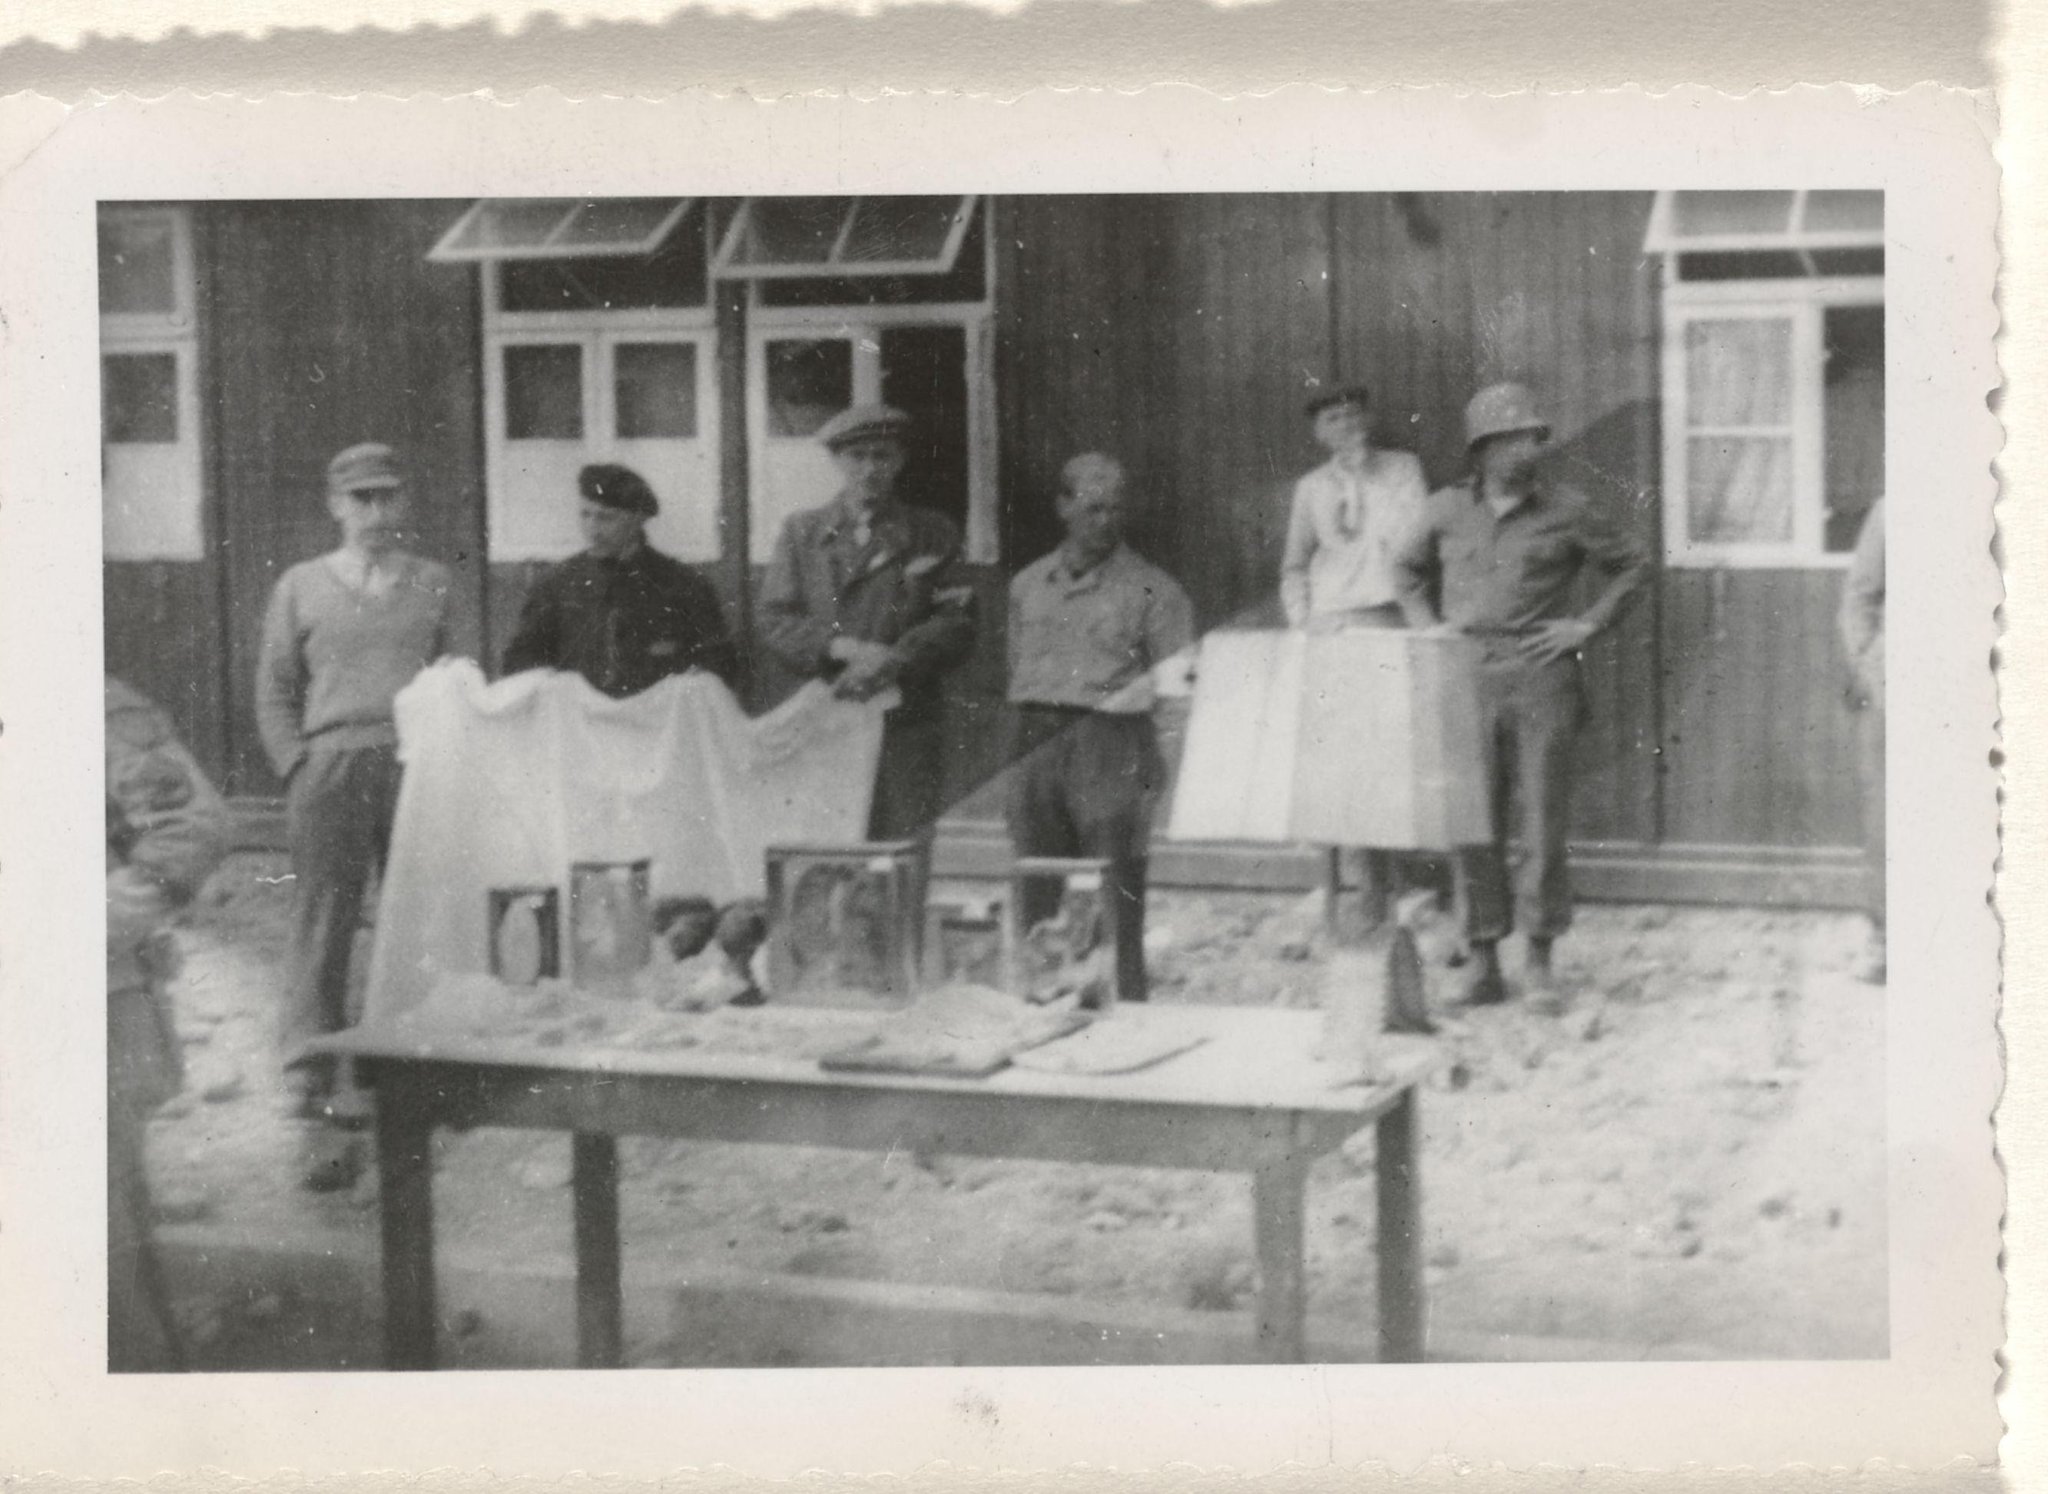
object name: photograph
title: Voormalige kampgevangenen en Amerikaanse soldaten, april 1945?, concentratiekamp Buchenwald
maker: Anonymous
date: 1904-1945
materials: photographic support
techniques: gelatin silver print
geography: buchenwald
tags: buchenwald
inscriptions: inscription: ‘K.Z. Buchenwald’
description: Voormalige kampgevangenen en Amerikaanse soldaten, april 1945?, concentratiekamp Buchenwald.